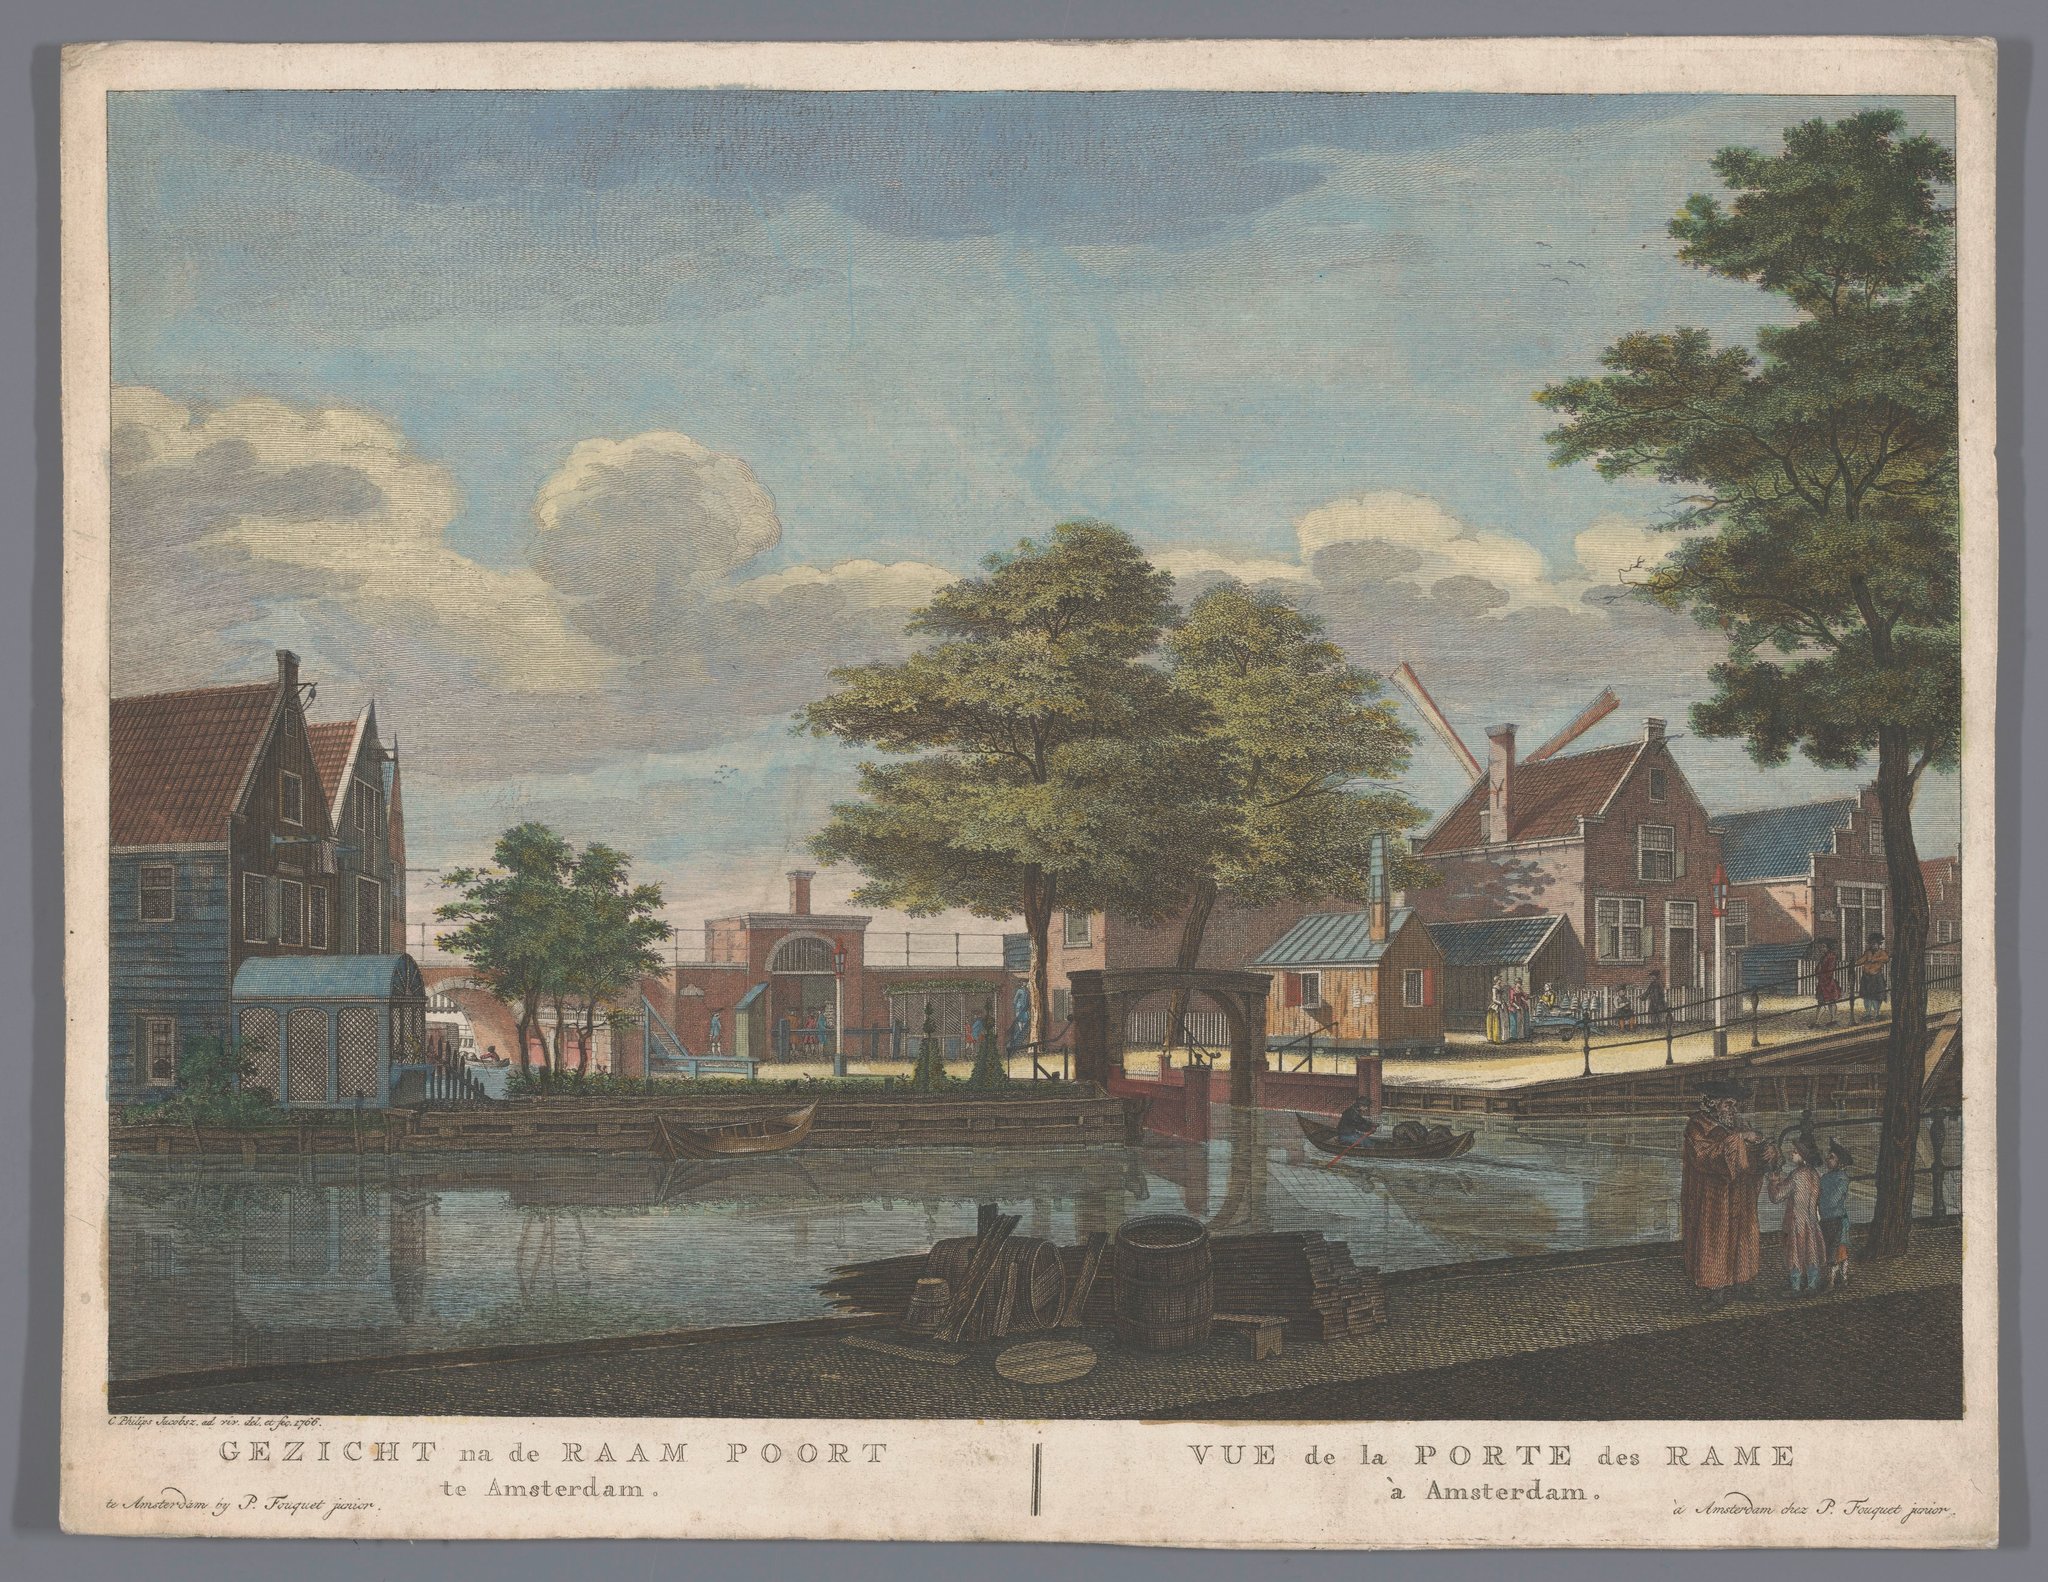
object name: print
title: Gezicht na de Raam Poort te Amsterdam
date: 1766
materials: cardboard, paper, watercolor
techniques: brush, etching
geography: amsterdam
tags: gate, entrance, canals, waters (in city) (+ city(-scape) with figures, staffage)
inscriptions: collector's mark: Lugt 2233